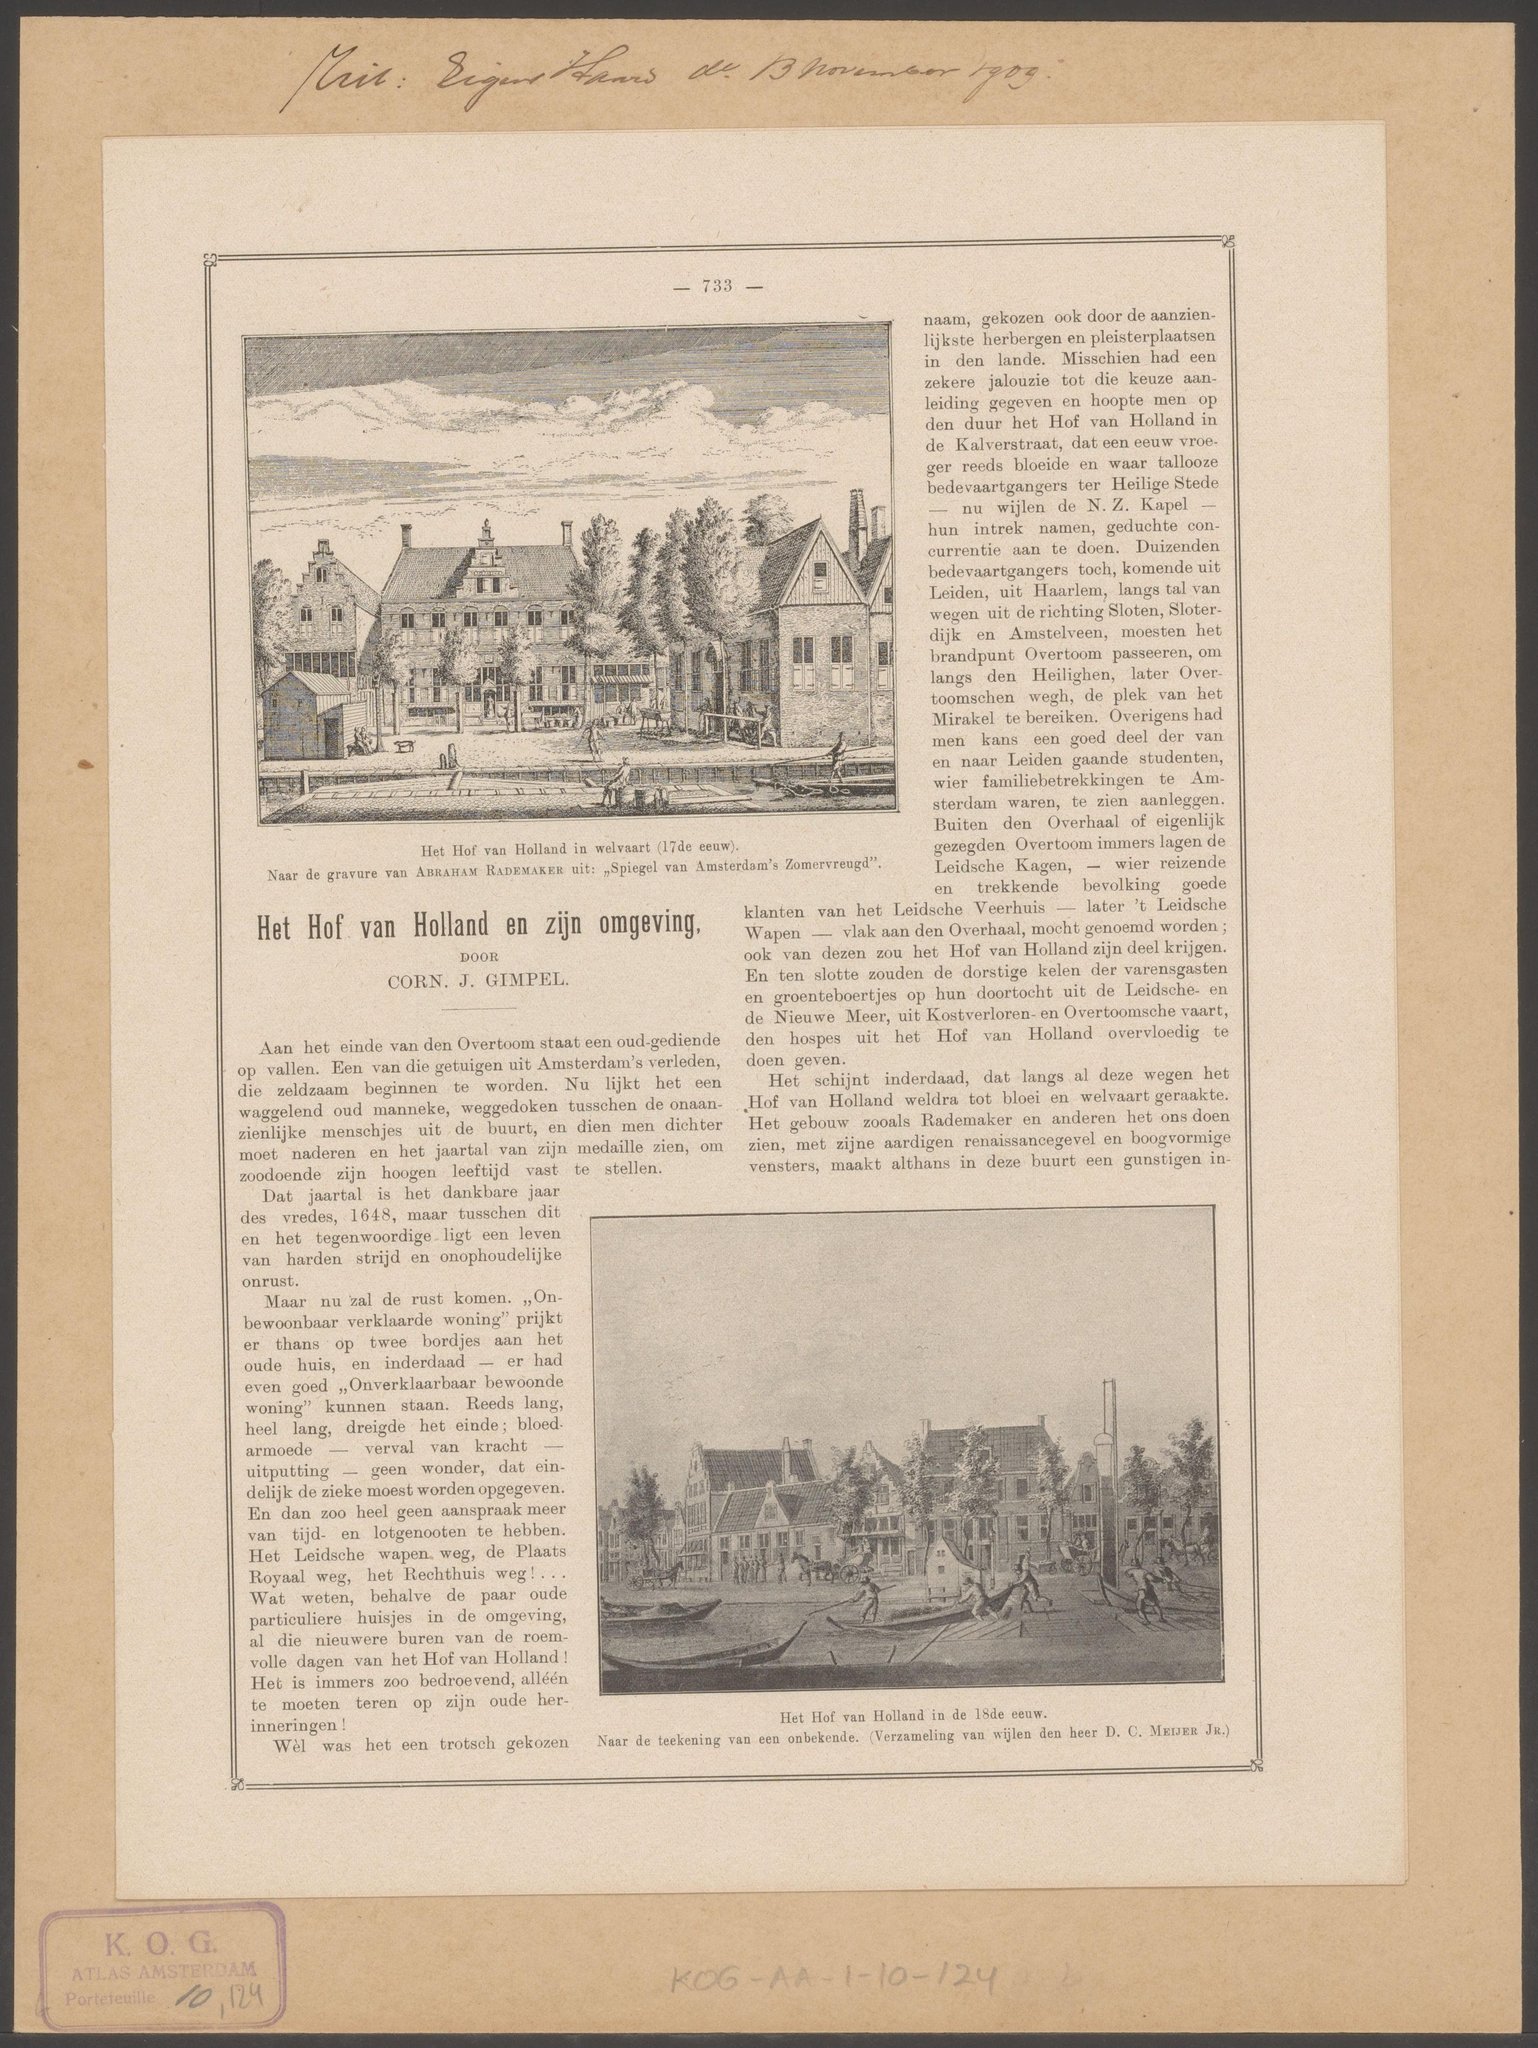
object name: photomechanical print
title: Gezichten op de herberg Het Hof van Holland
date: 1909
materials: paper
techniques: letterpress printing, line block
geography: haarlem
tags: city-view in general; 'veduta', hotel, hostelry, inn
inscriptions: collector's mark: ‘10,124’ Lugt 1641b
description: Onderwerpsrubriek binnen de Atlas Amsterdam: Overtoom. Met lijncliché onder de bladzijde.